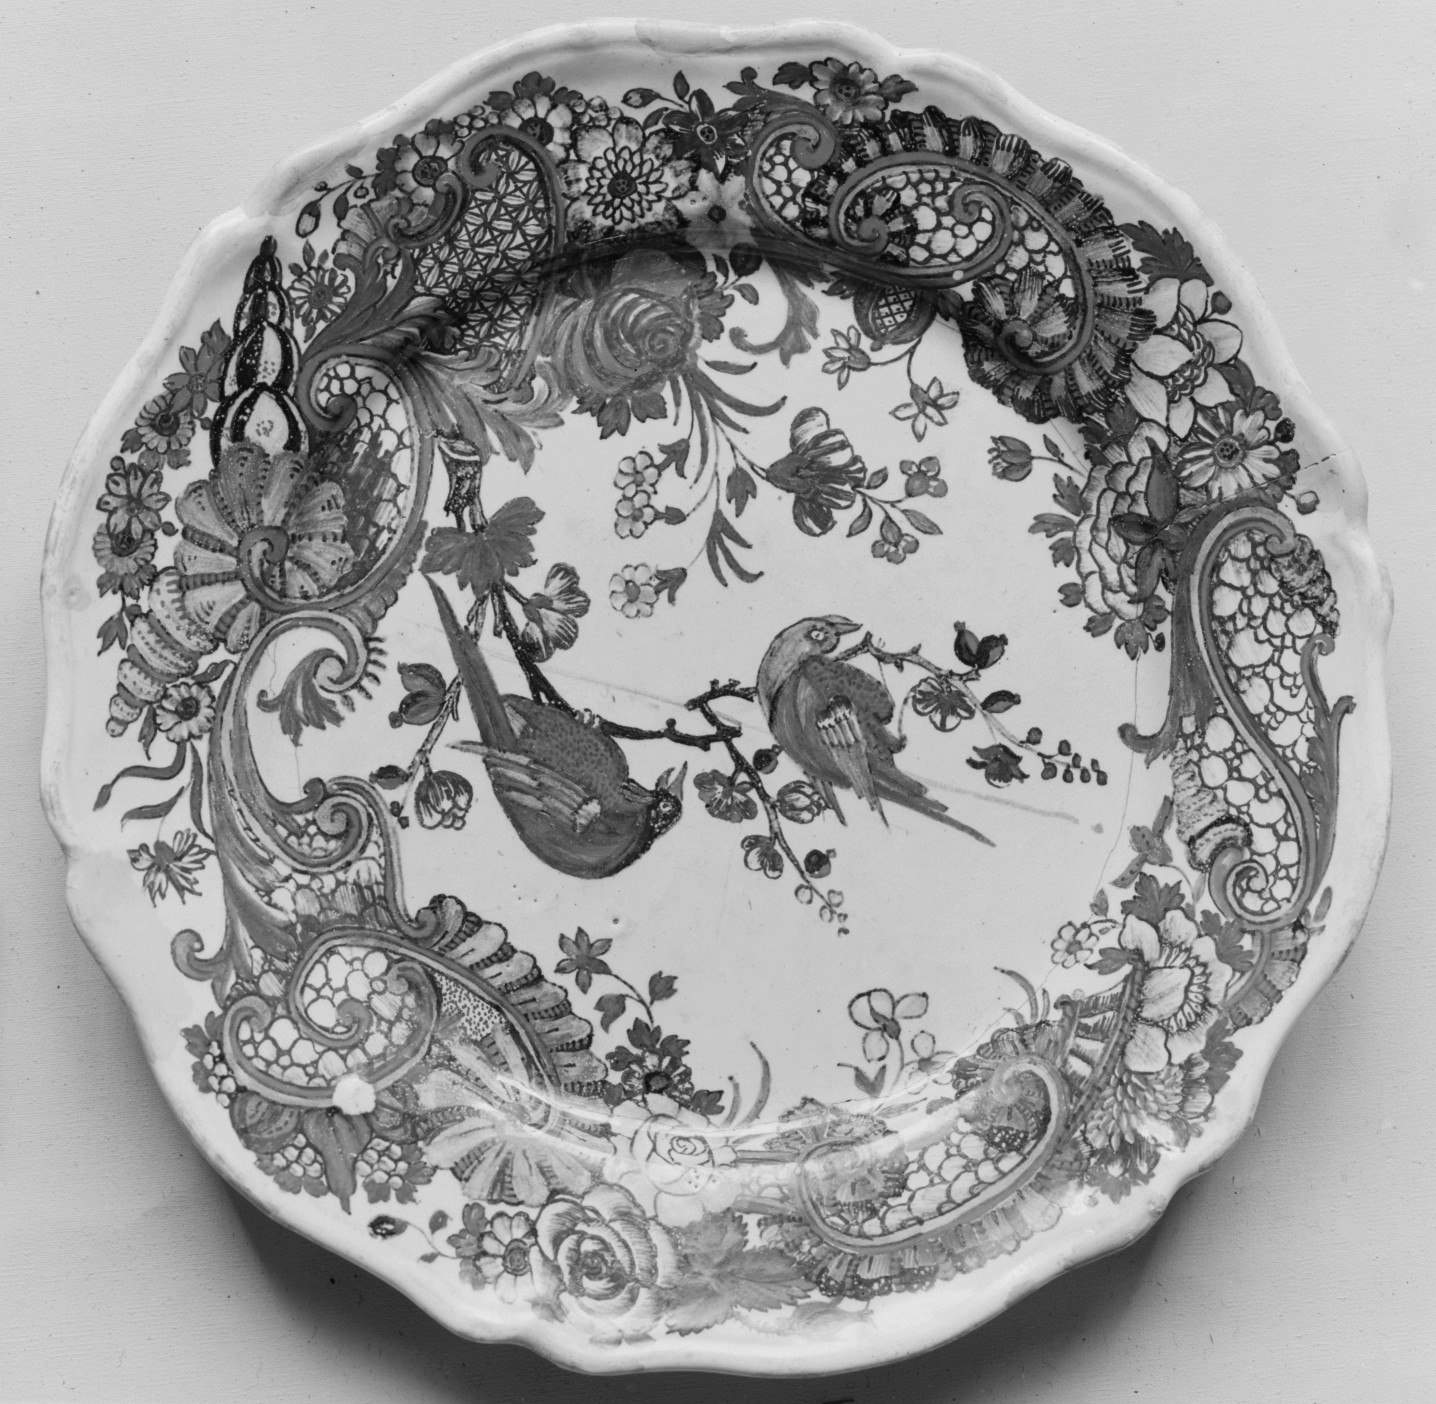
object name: plate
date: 1750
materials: faience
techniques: glazing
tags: birds,flowers